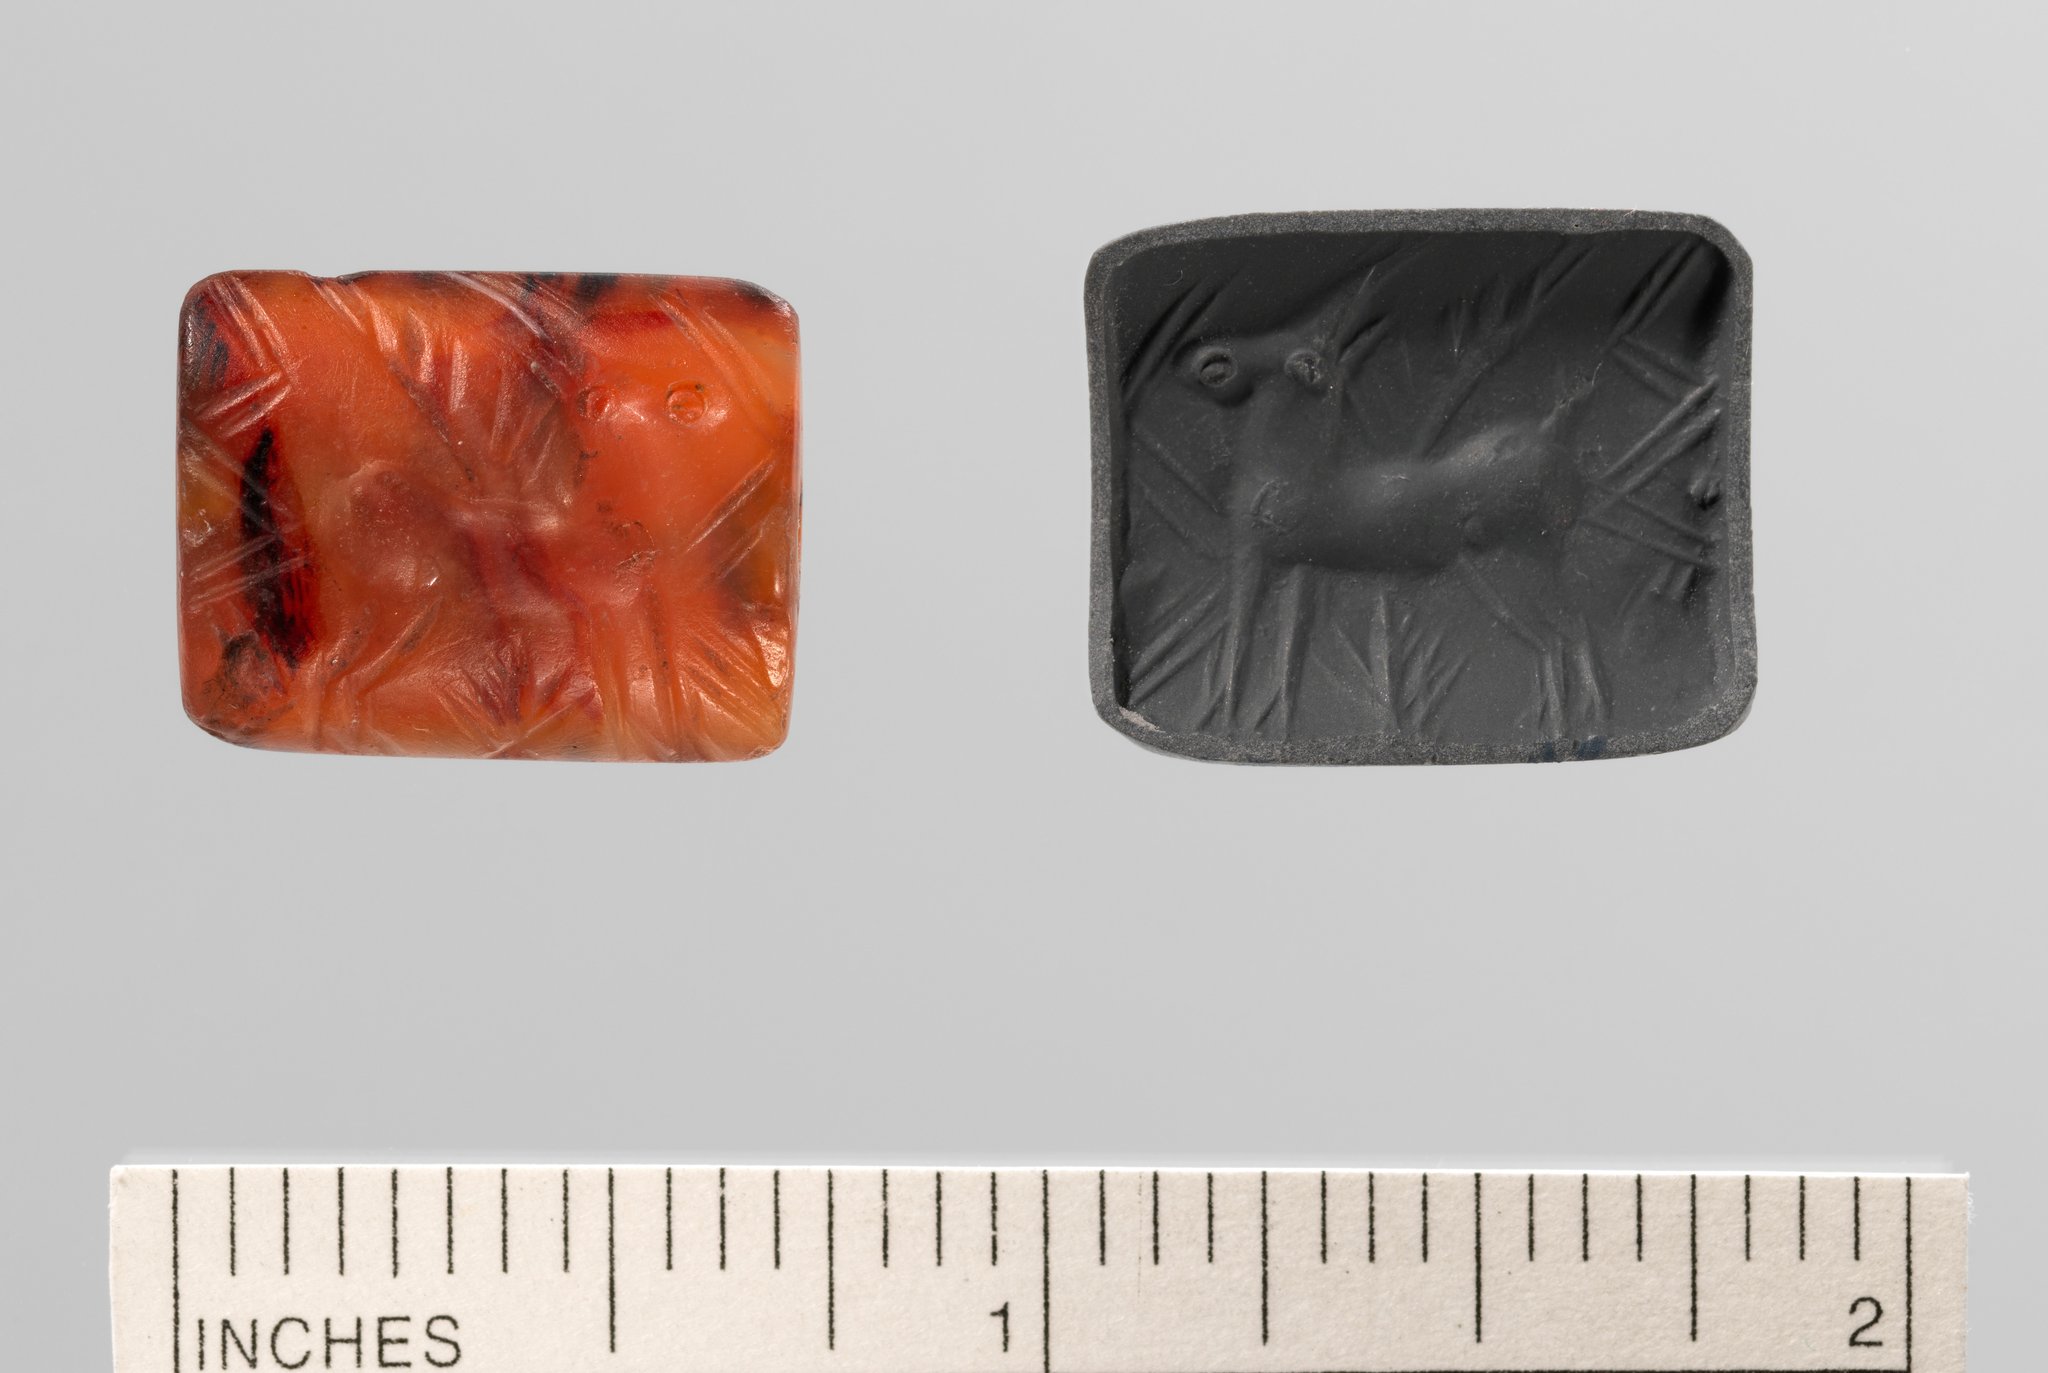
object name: seal, cushion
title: Carnelian Cushion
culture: minoan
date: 1600-1450 BCE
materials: gemstone